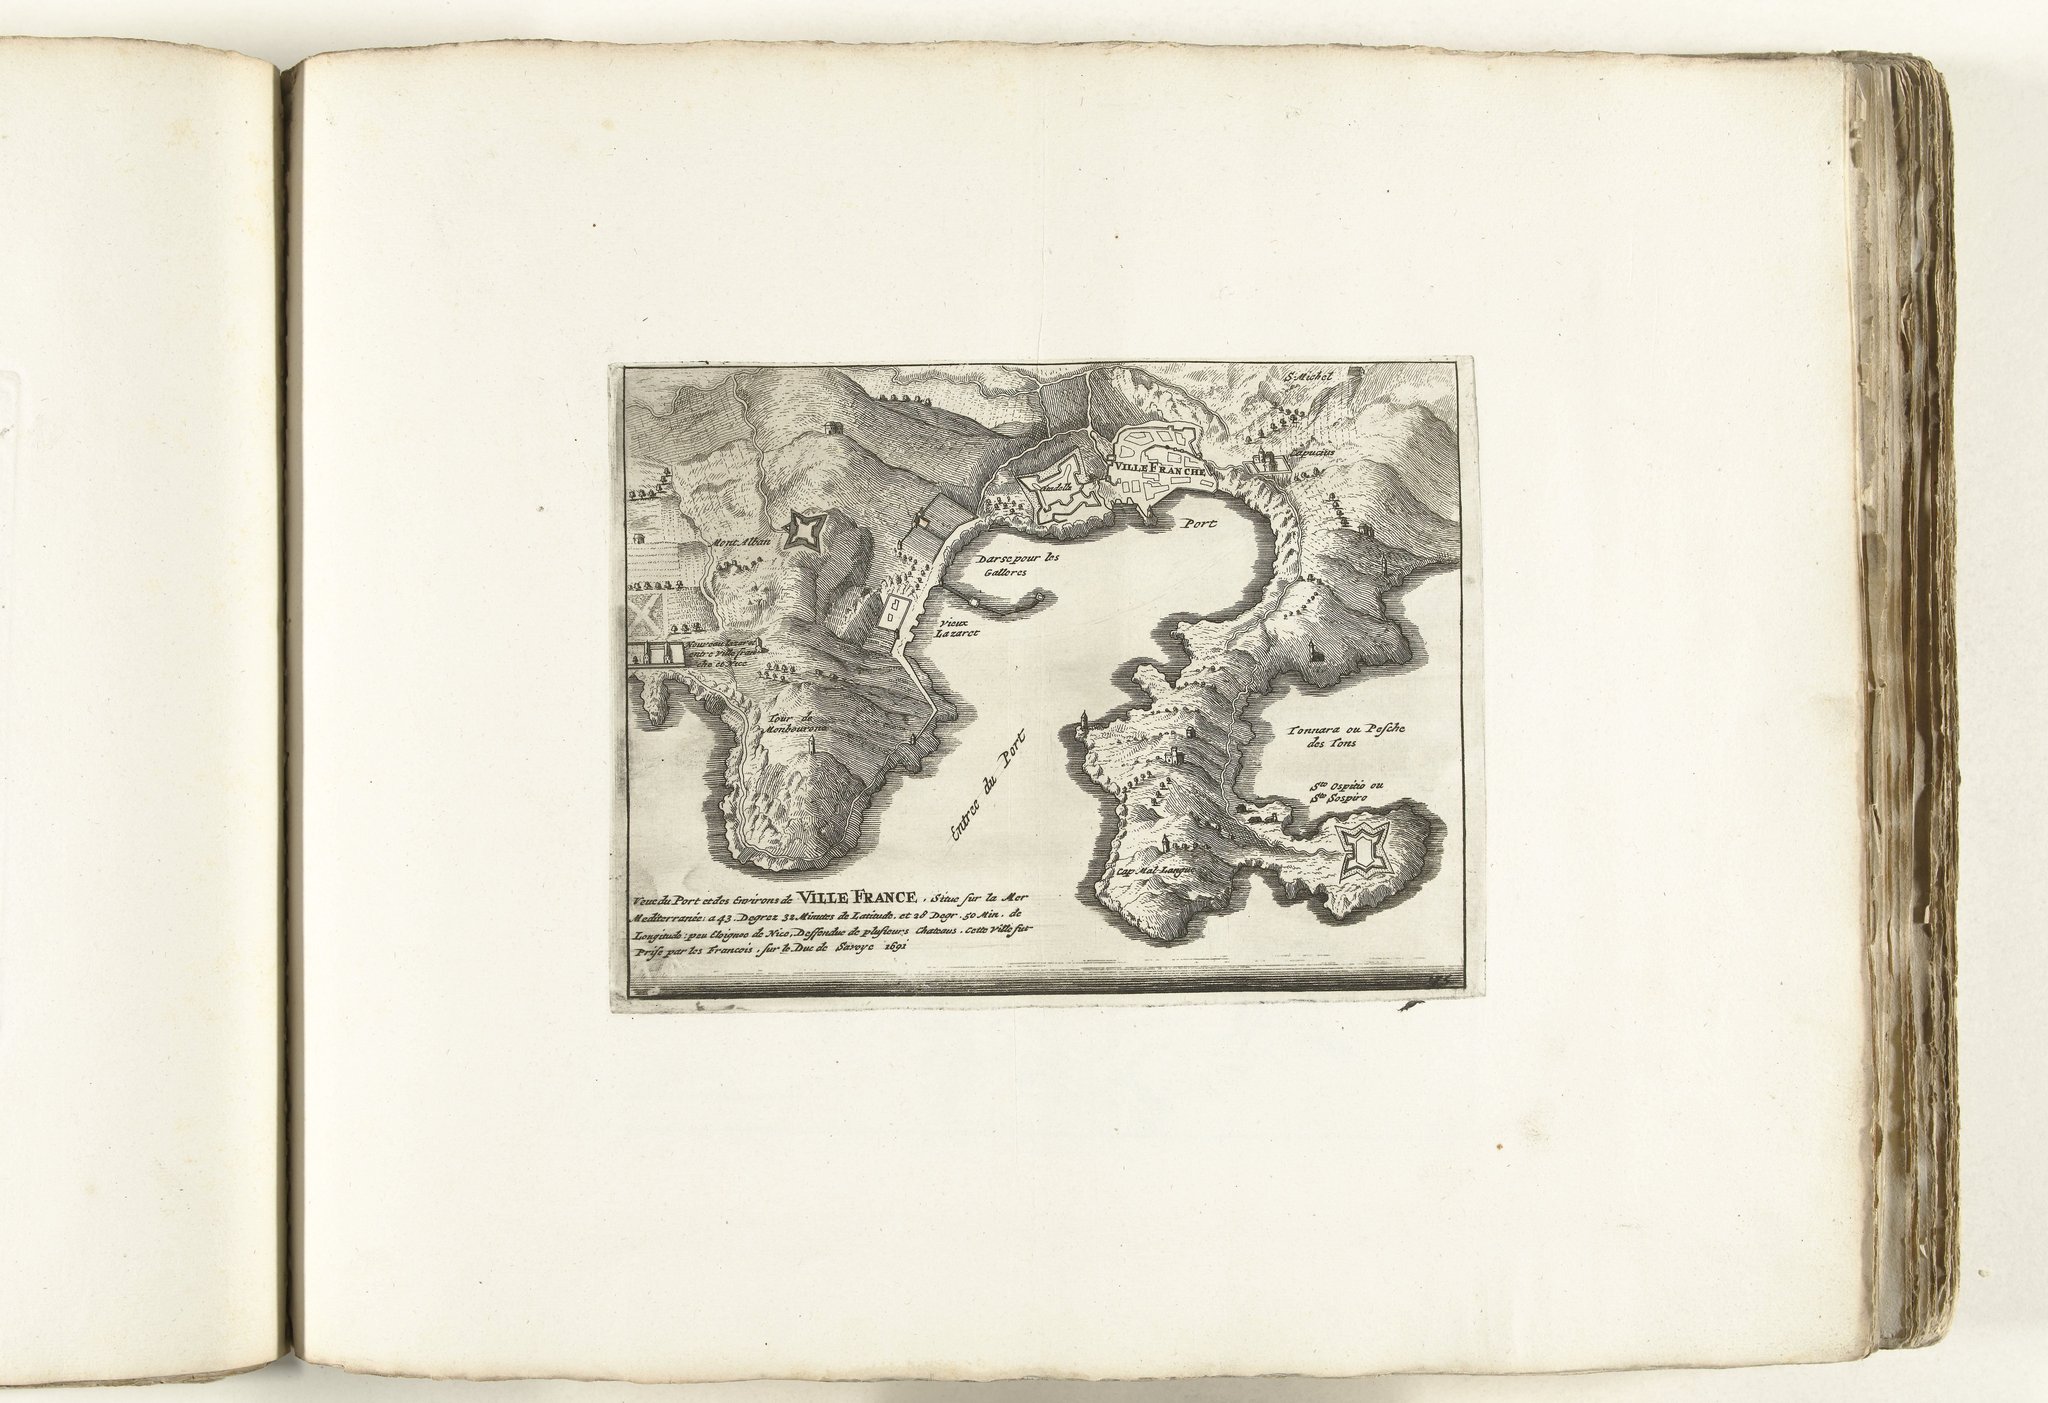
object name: print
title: Veue du Port et des Environs de Ville France (...)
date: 1702-1703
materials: paper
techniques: etching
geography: amsterdam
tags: maps of separate countries or regions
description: Kaart van de Franse kuststad Villefranche-sur-Mer en omgeving. Plaat nr. 175 in het prentwerk bestaande in totaal uit 276 genummerde platen van vermaarde sterke steden en vestingen in het kader van de Spaanse Successieoorlog. Voor het merendeel zijn deze platen gekopieerd naar de anonieme Franse platen: in Les forces de l'Europe en in: Le theatre de la guerre, dans les Pays-Bas, beide oorspronkelijk uitgegeven door Nicolas de Fer te Parijs (1693-1697) in het kader van de Negenjarige Oorlog. Titel en opschriften in de plaat in het Frans.